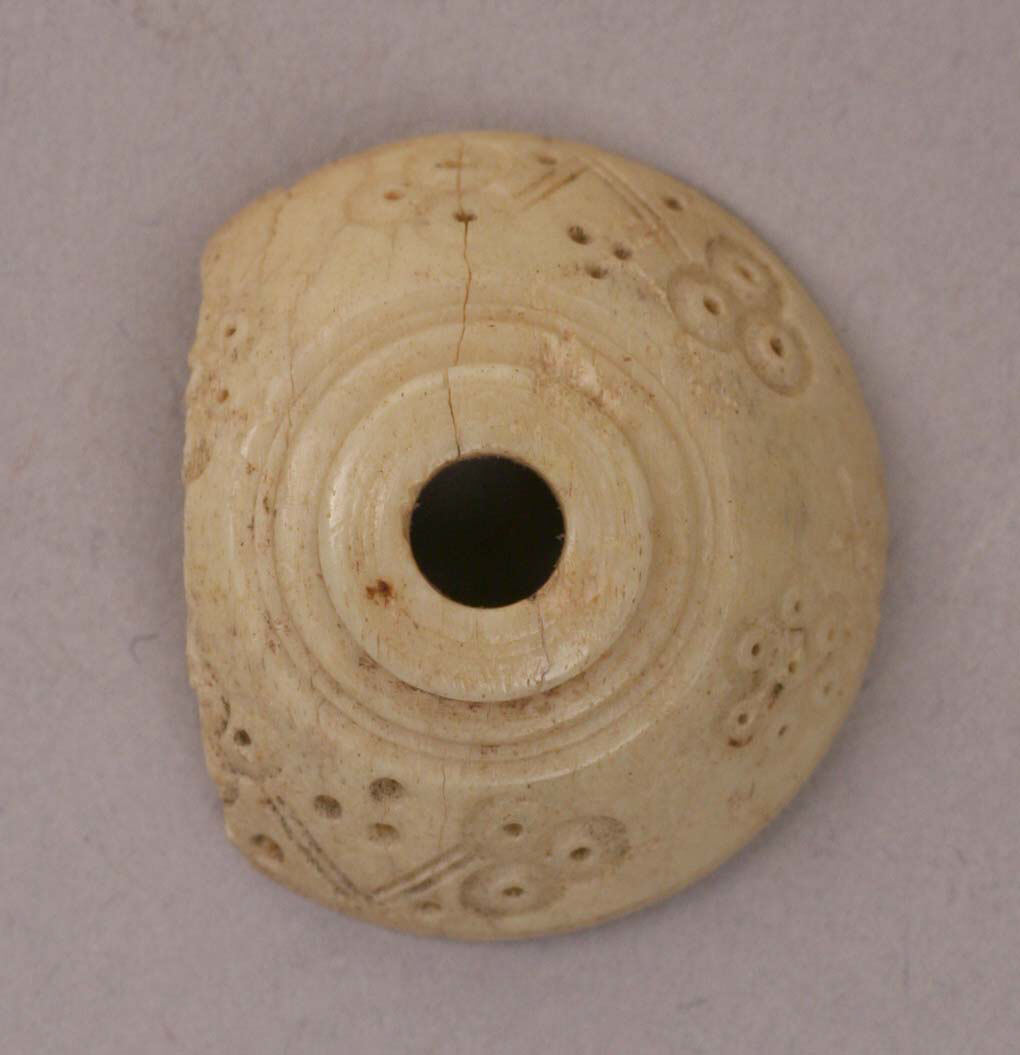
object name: button or bead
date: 801-1000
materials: bone, paint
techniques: incising, inlay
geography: iran